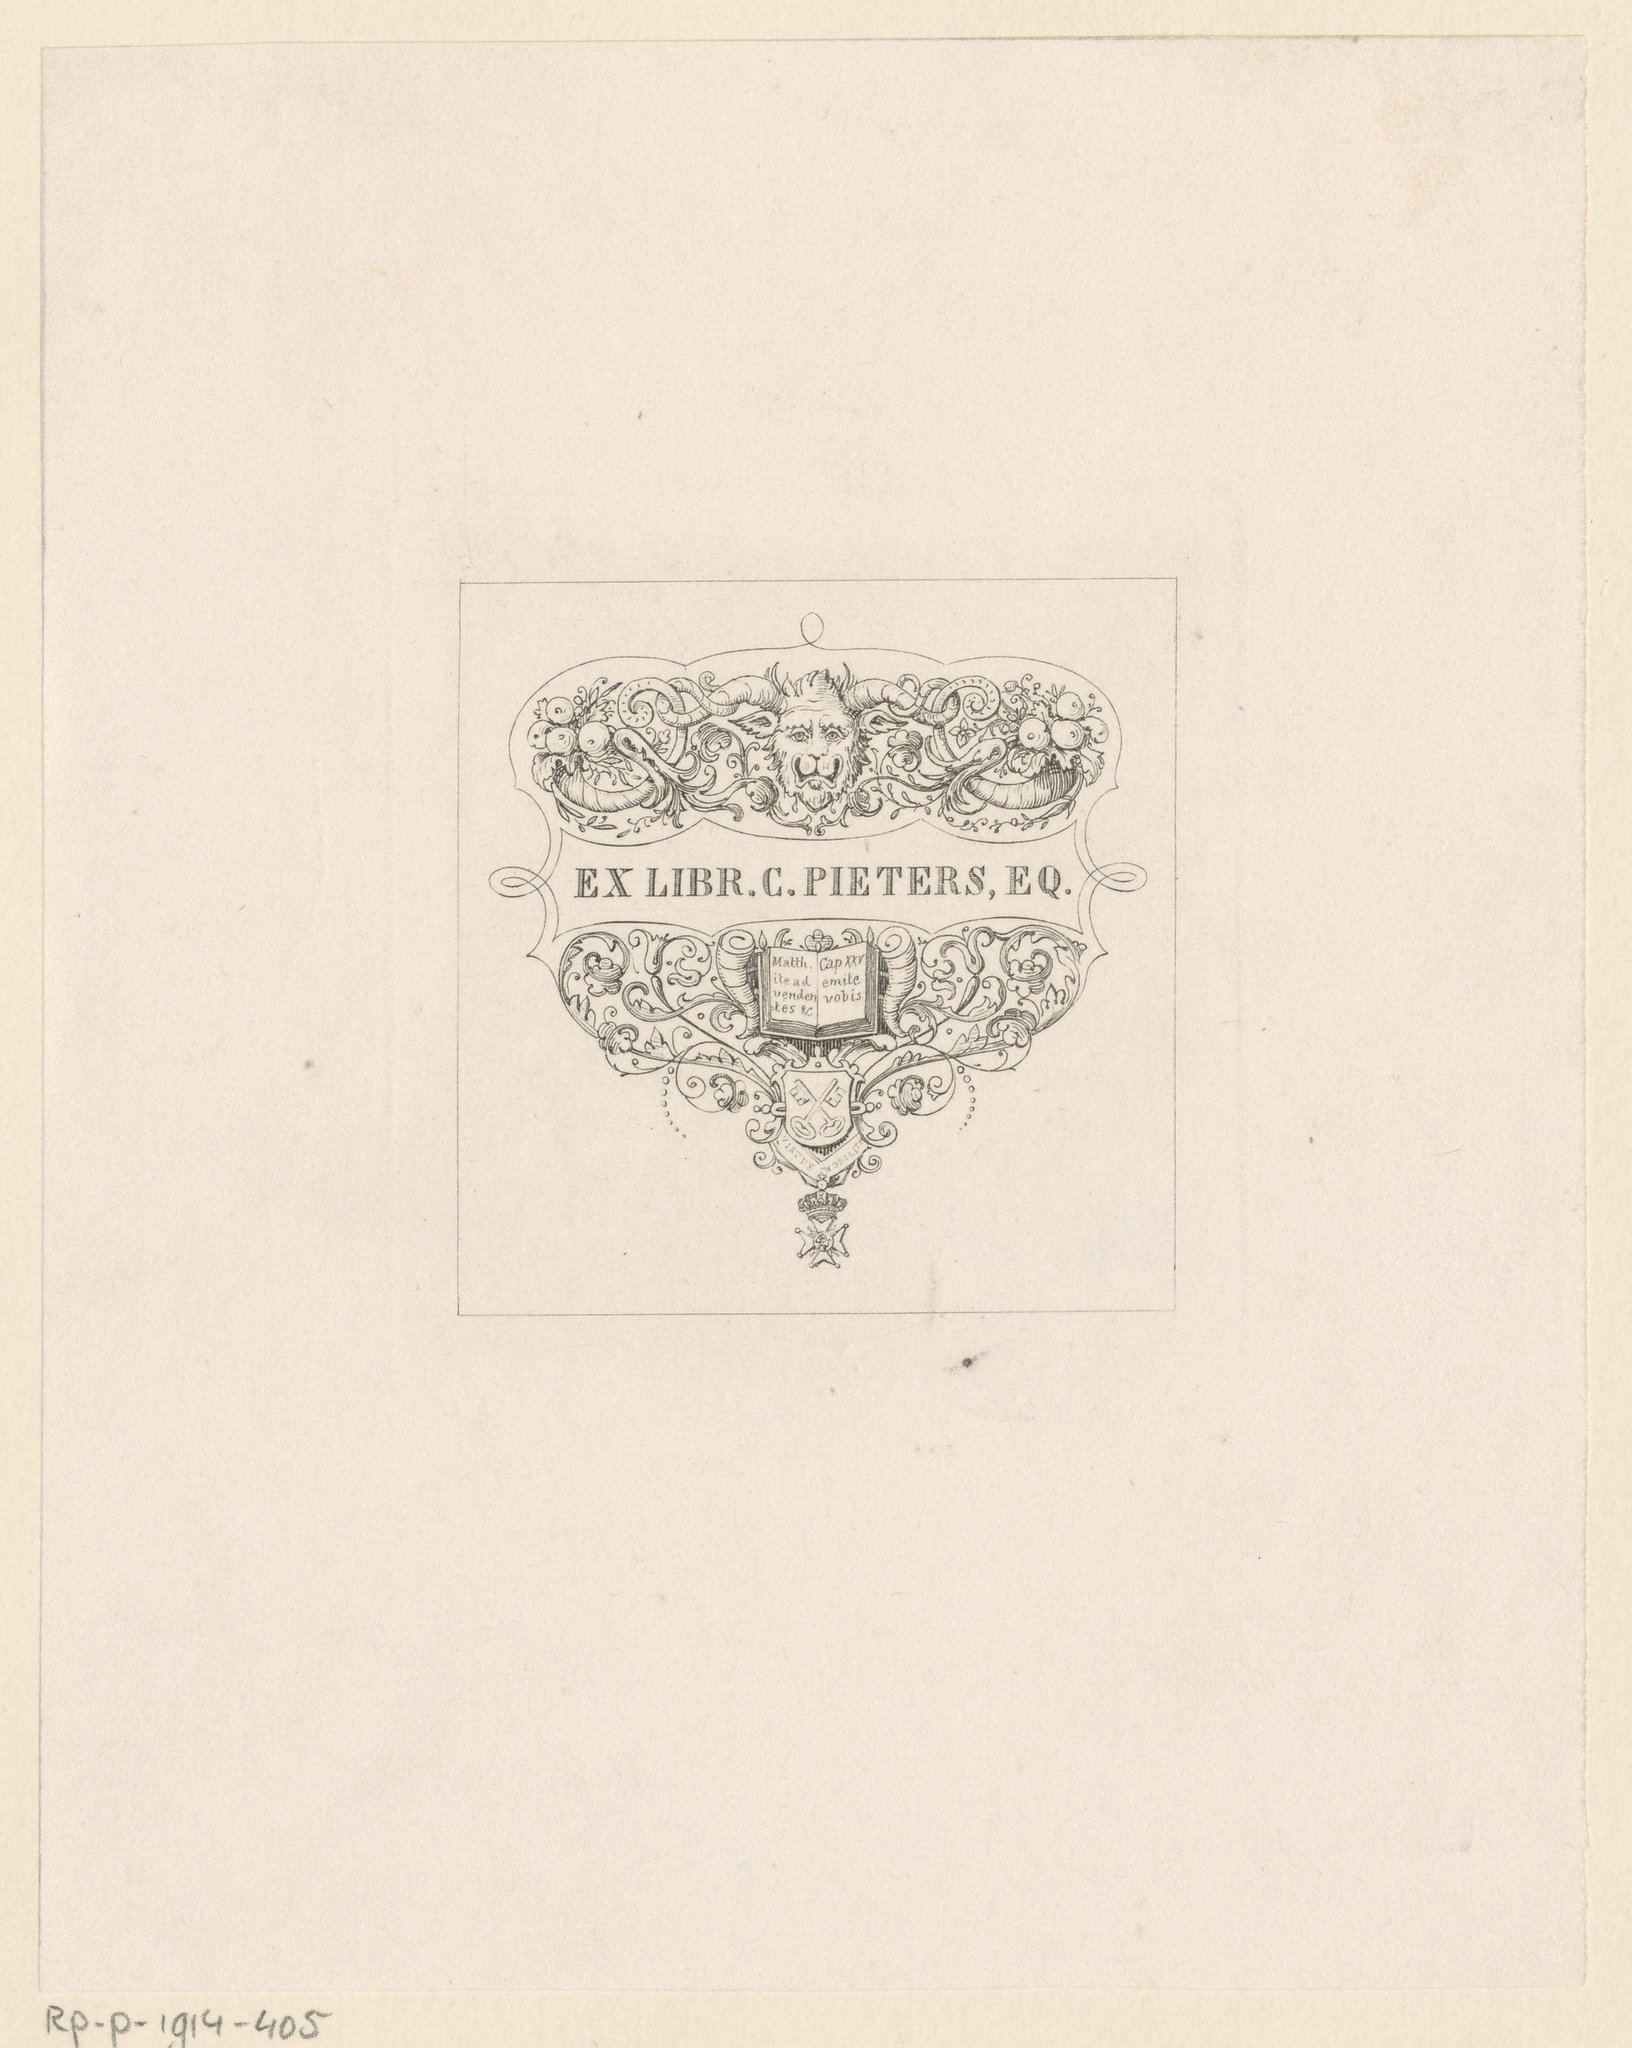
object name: bookplate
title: Virtus Nobilita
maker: Anonymous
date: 1850-1899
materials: paper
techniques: engraving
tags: satyr(s) (in general), armorial bearing, heraldry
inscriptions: collector's mark: Lugt 2233, collector's mark: Lugt 2760